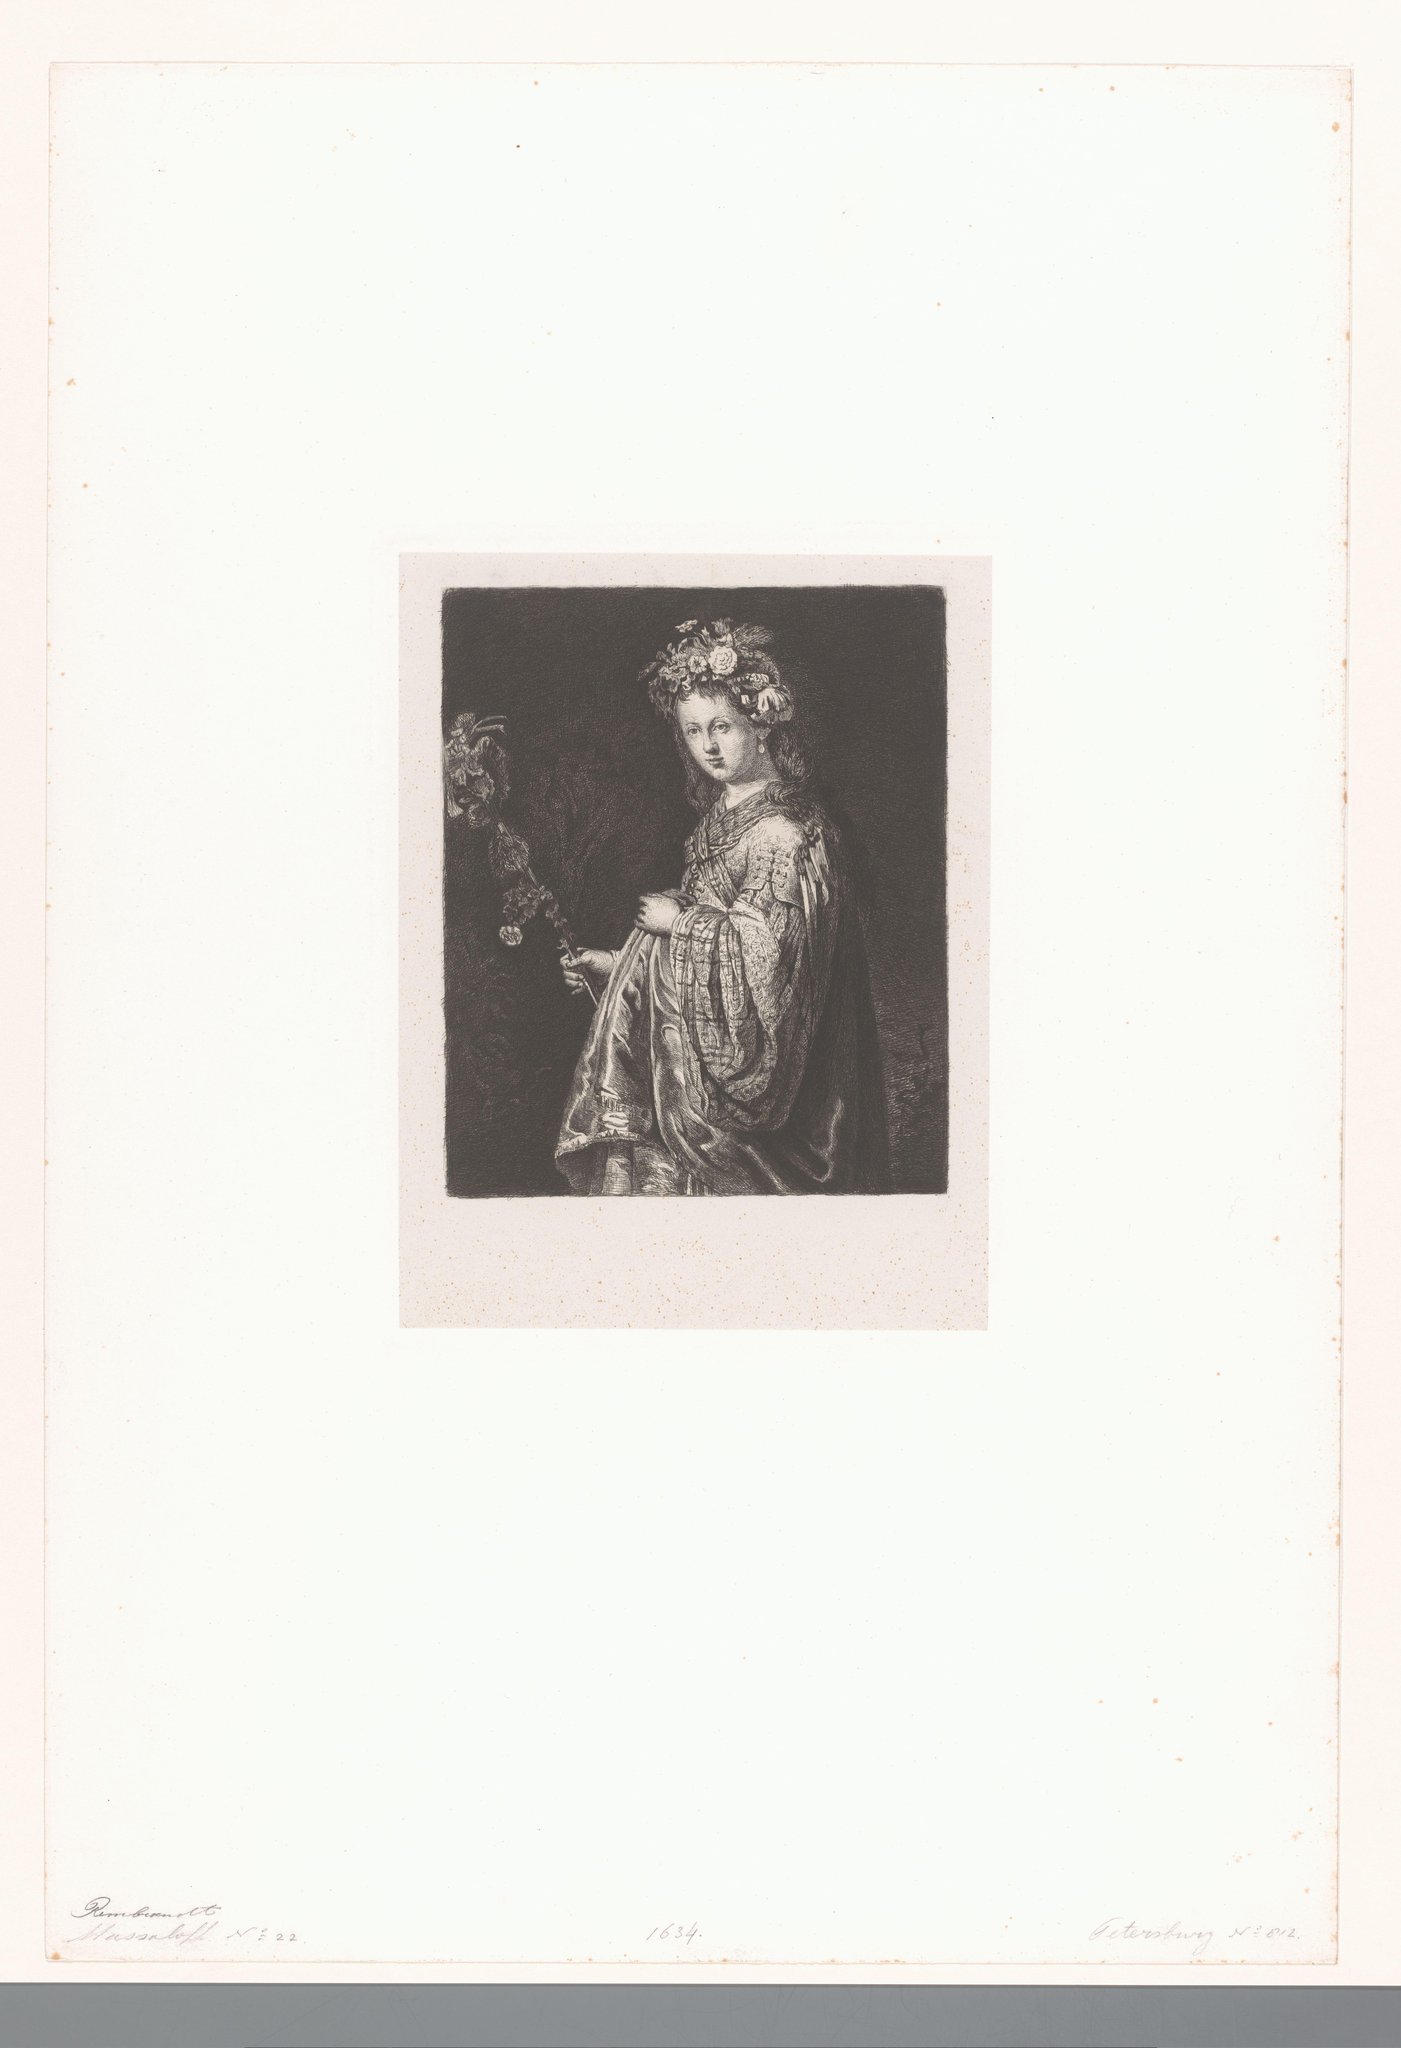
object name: print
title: Flora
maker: nikolay semyonovich mosolov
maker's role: print maker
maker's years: 1847-1914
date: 1857-1914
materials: paper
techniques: drypoint, etching, intaglio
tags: historical persons - bb - woman, (story of) flora